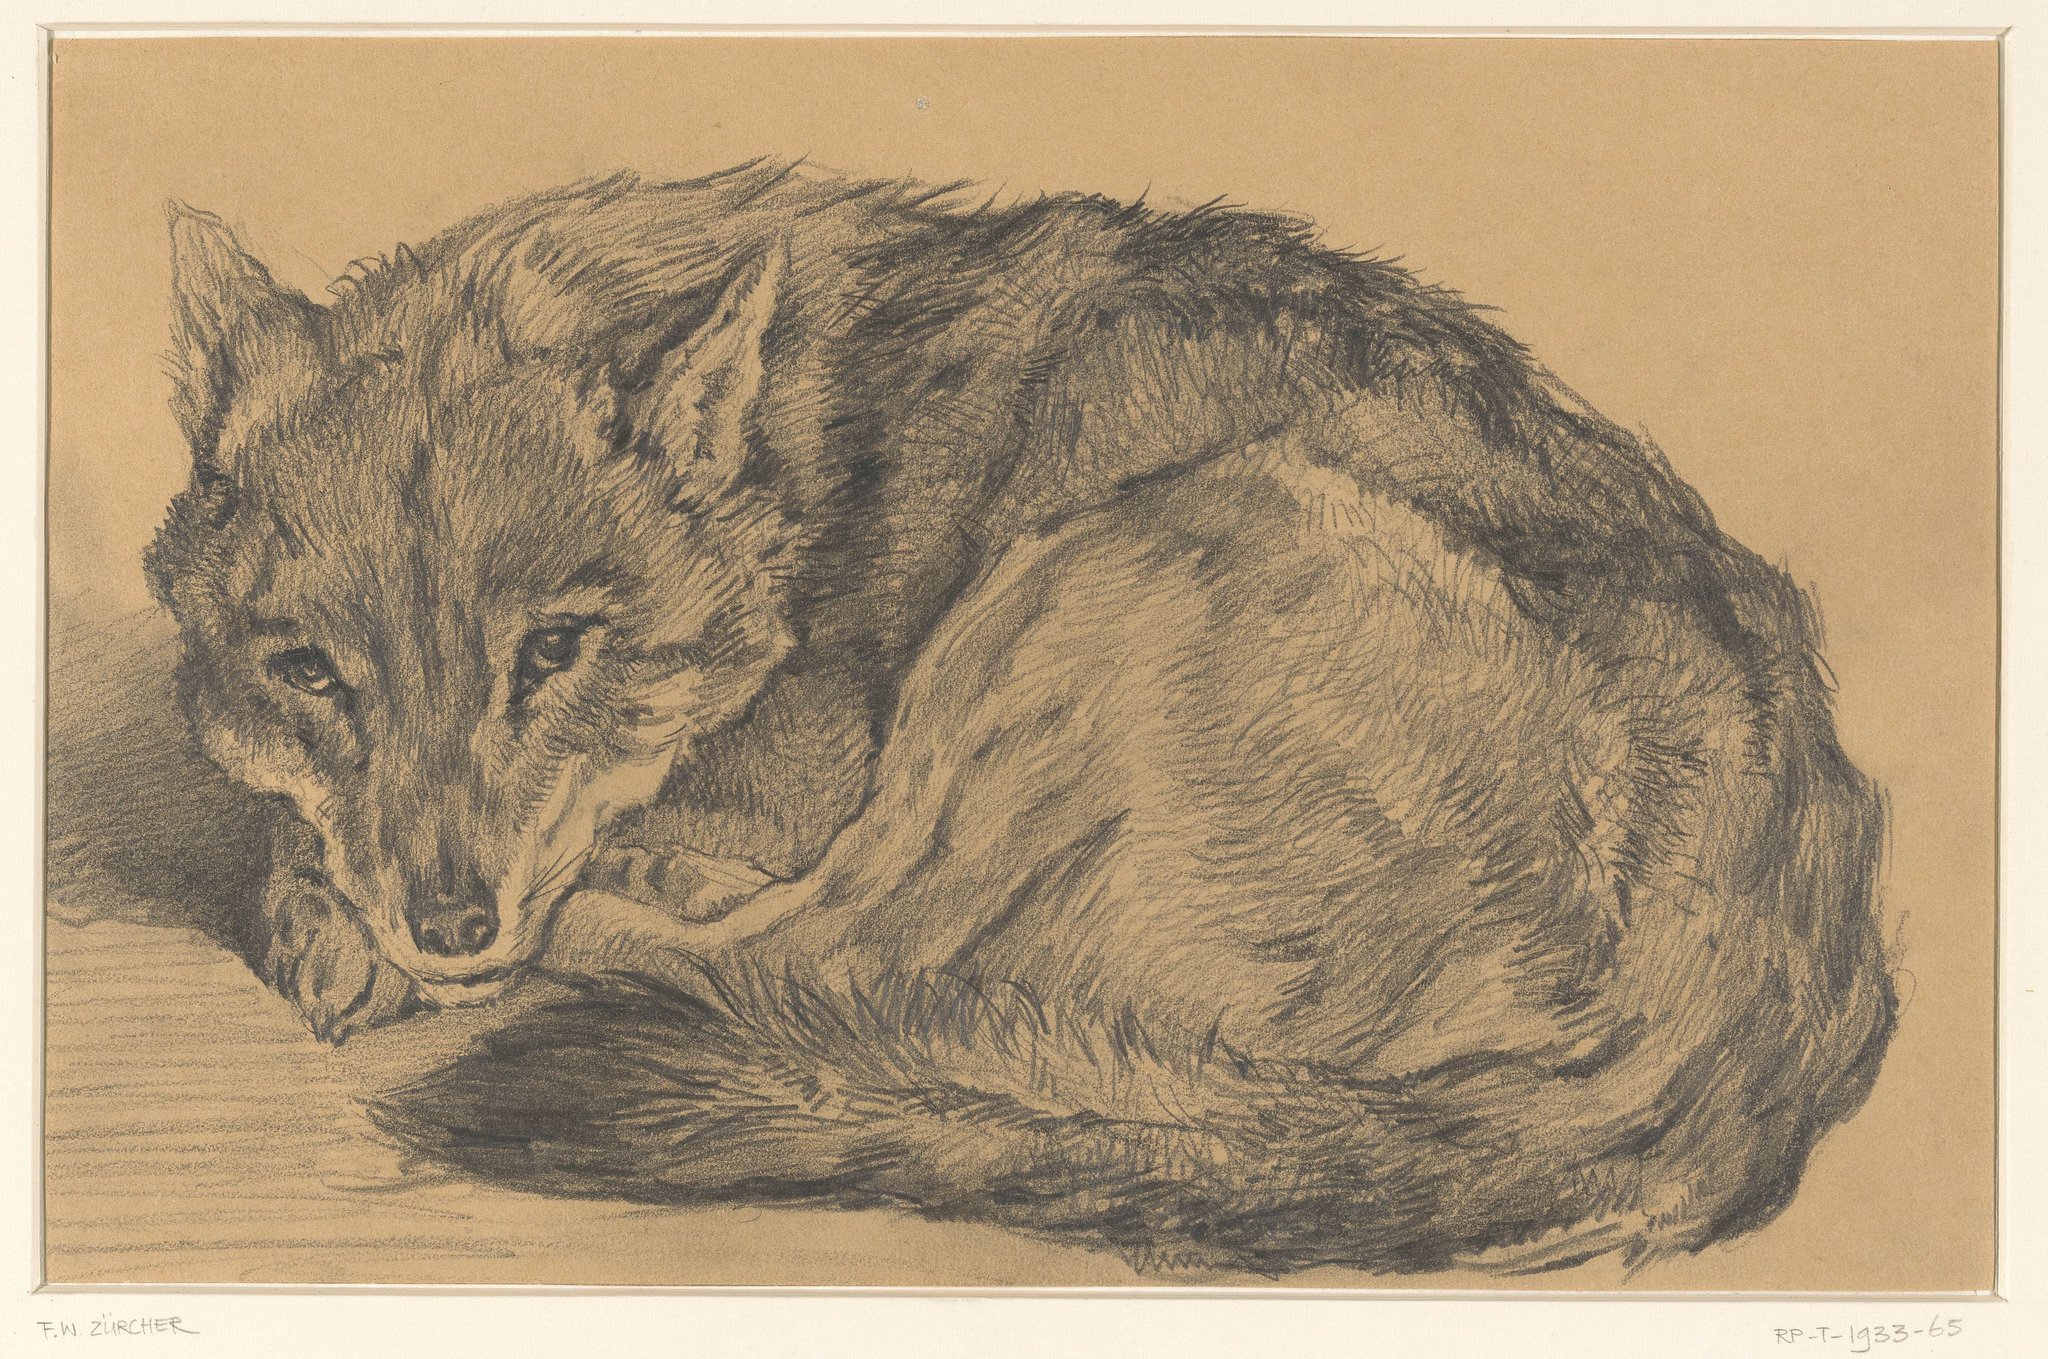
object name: drawing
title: Liggende vos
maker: frederik willem zürcher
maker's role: draughtsman, print maker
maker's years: 1835-1894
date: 1845-1894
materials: paper, pencil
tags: beasts of prey, predatory animals: fox